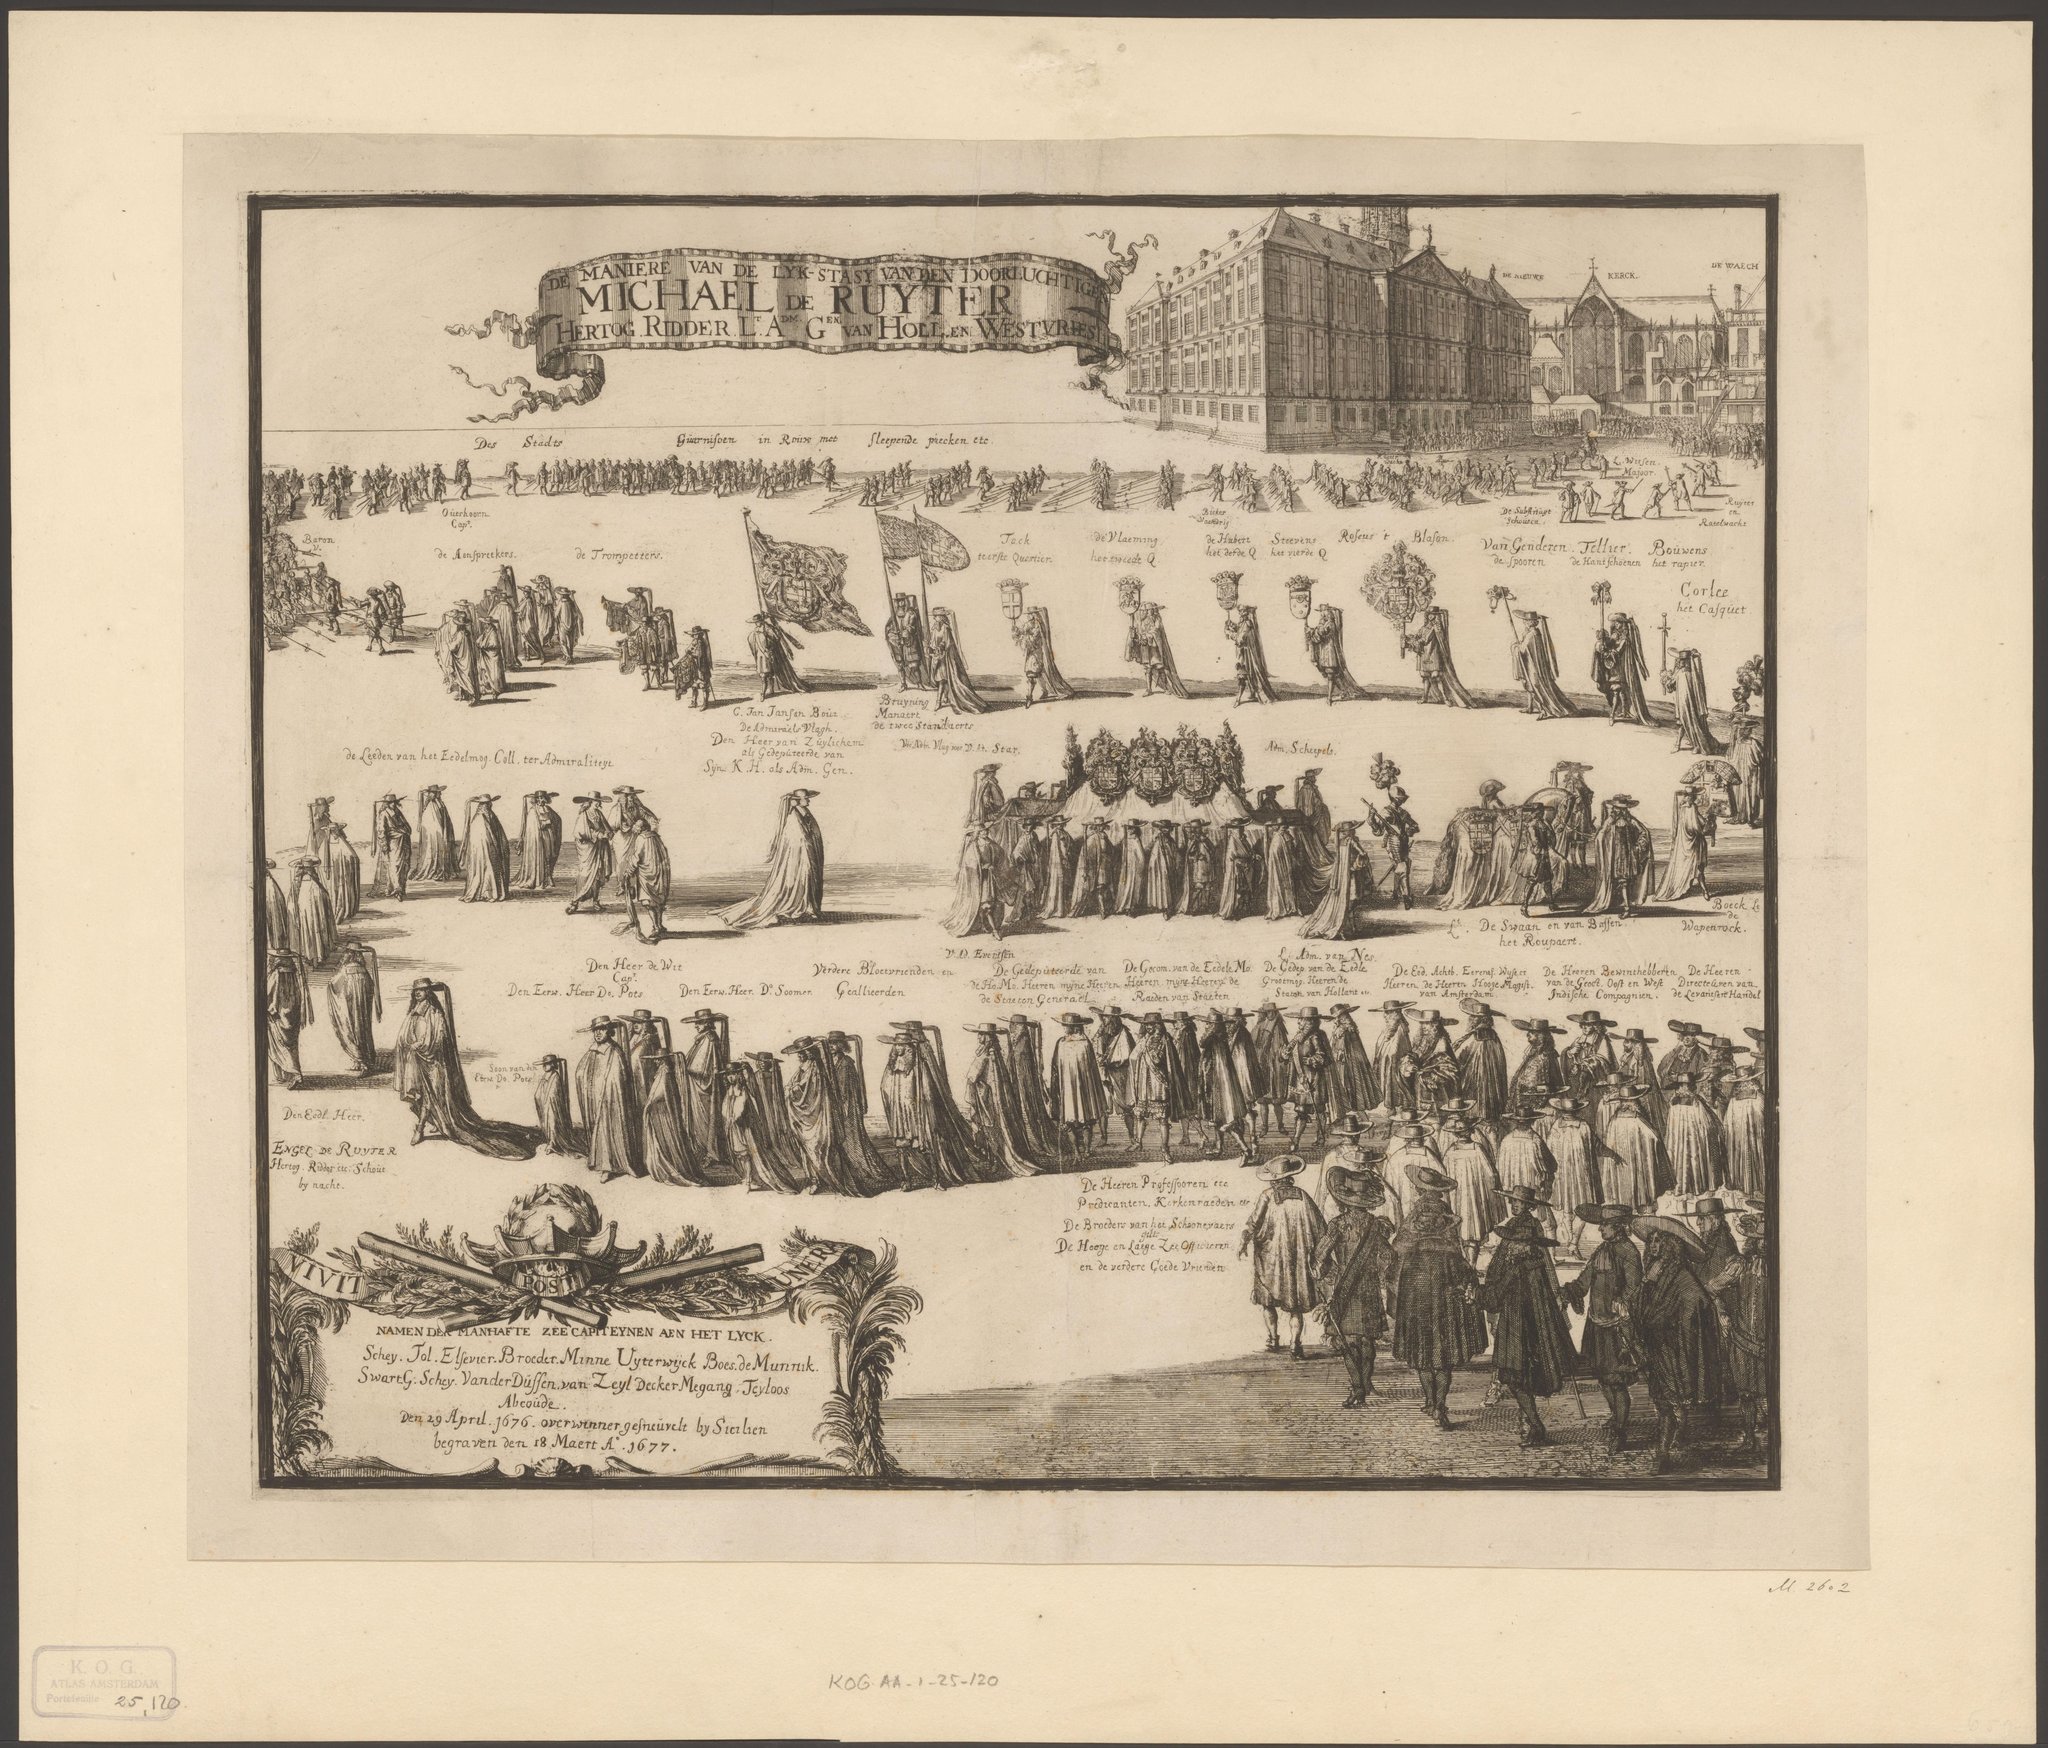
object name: print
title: Begrafenisstoet van Michiel Adriaenszoon de Ruyter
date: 1677-1679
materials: paper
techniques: etching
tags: michiel adriaenszoon de ruyter, cortege, funeral procession, commander-in-chief, admiral, historical persons (portraits and scenes from the life)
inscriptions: collector's mark: ‘25.120’ Lugt 1641b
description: Onderwerpsrubriek binnen de Atlas Amsterdam: Krijgswezen I: De Admiraliteit van Amsterdam, C. Michiel Adriaensz. de Ruyter.